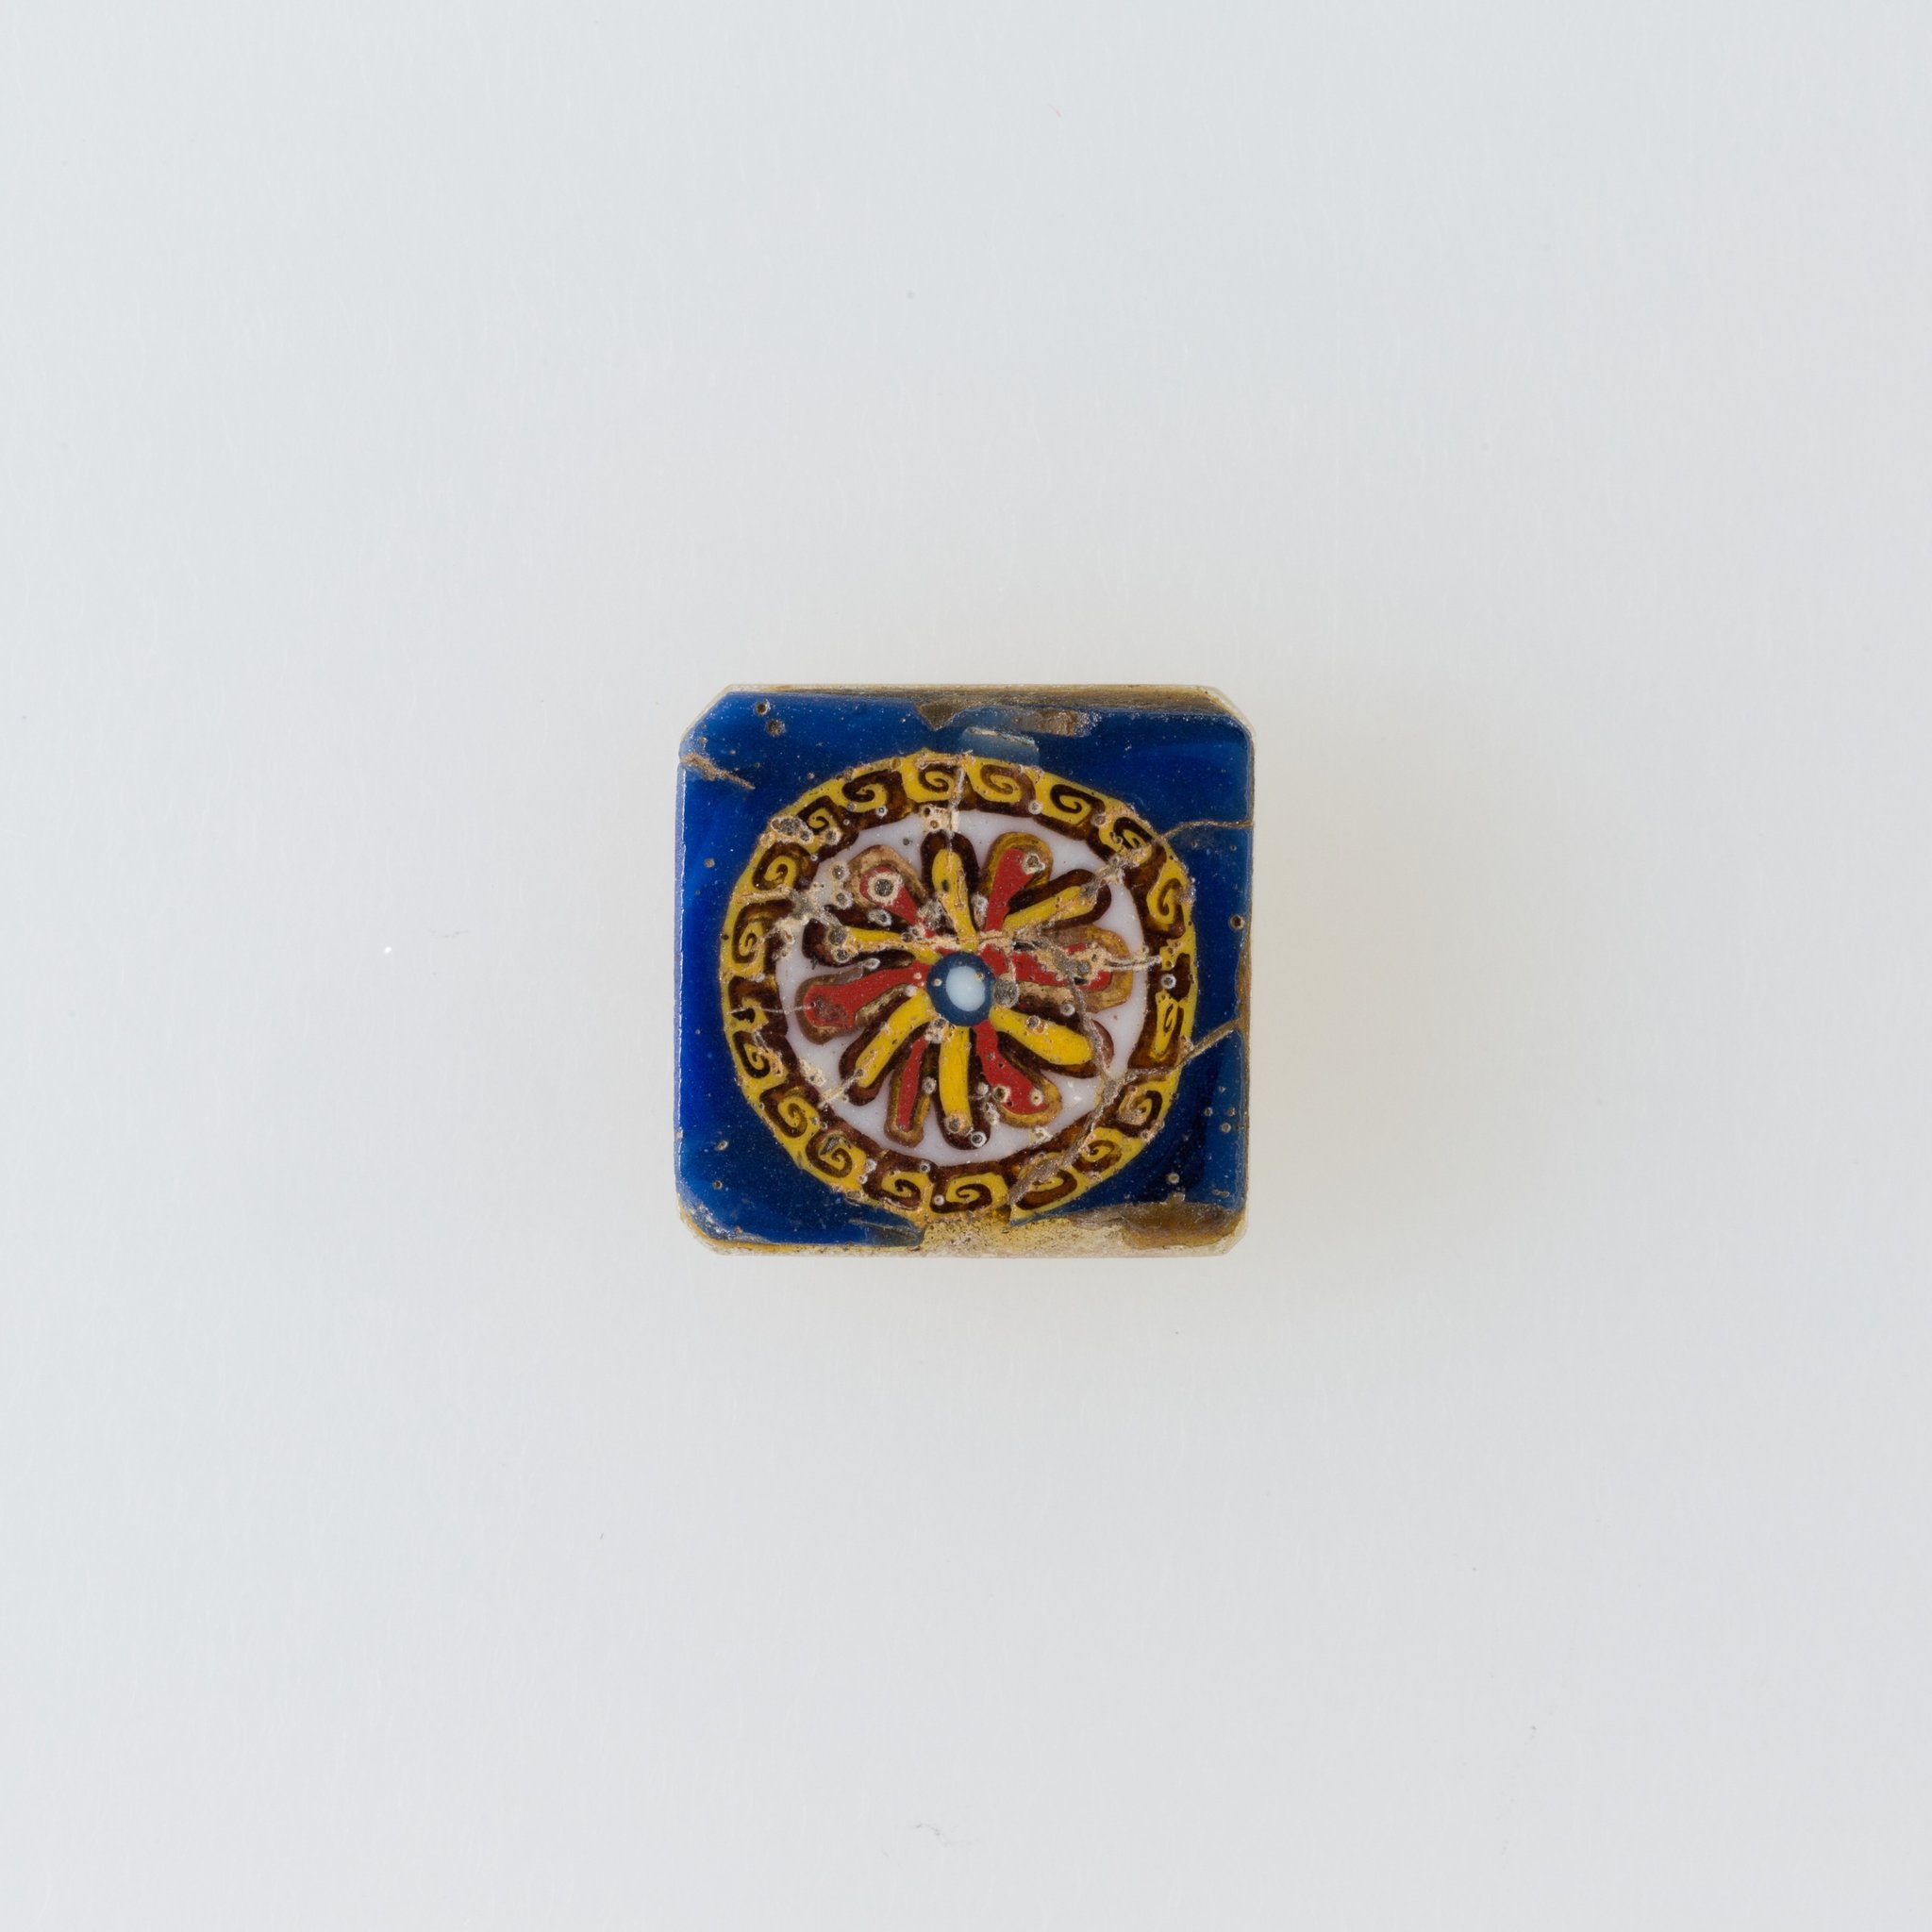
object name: inlay, rosette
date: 100 BCE-100 CE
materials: glass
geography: egypt